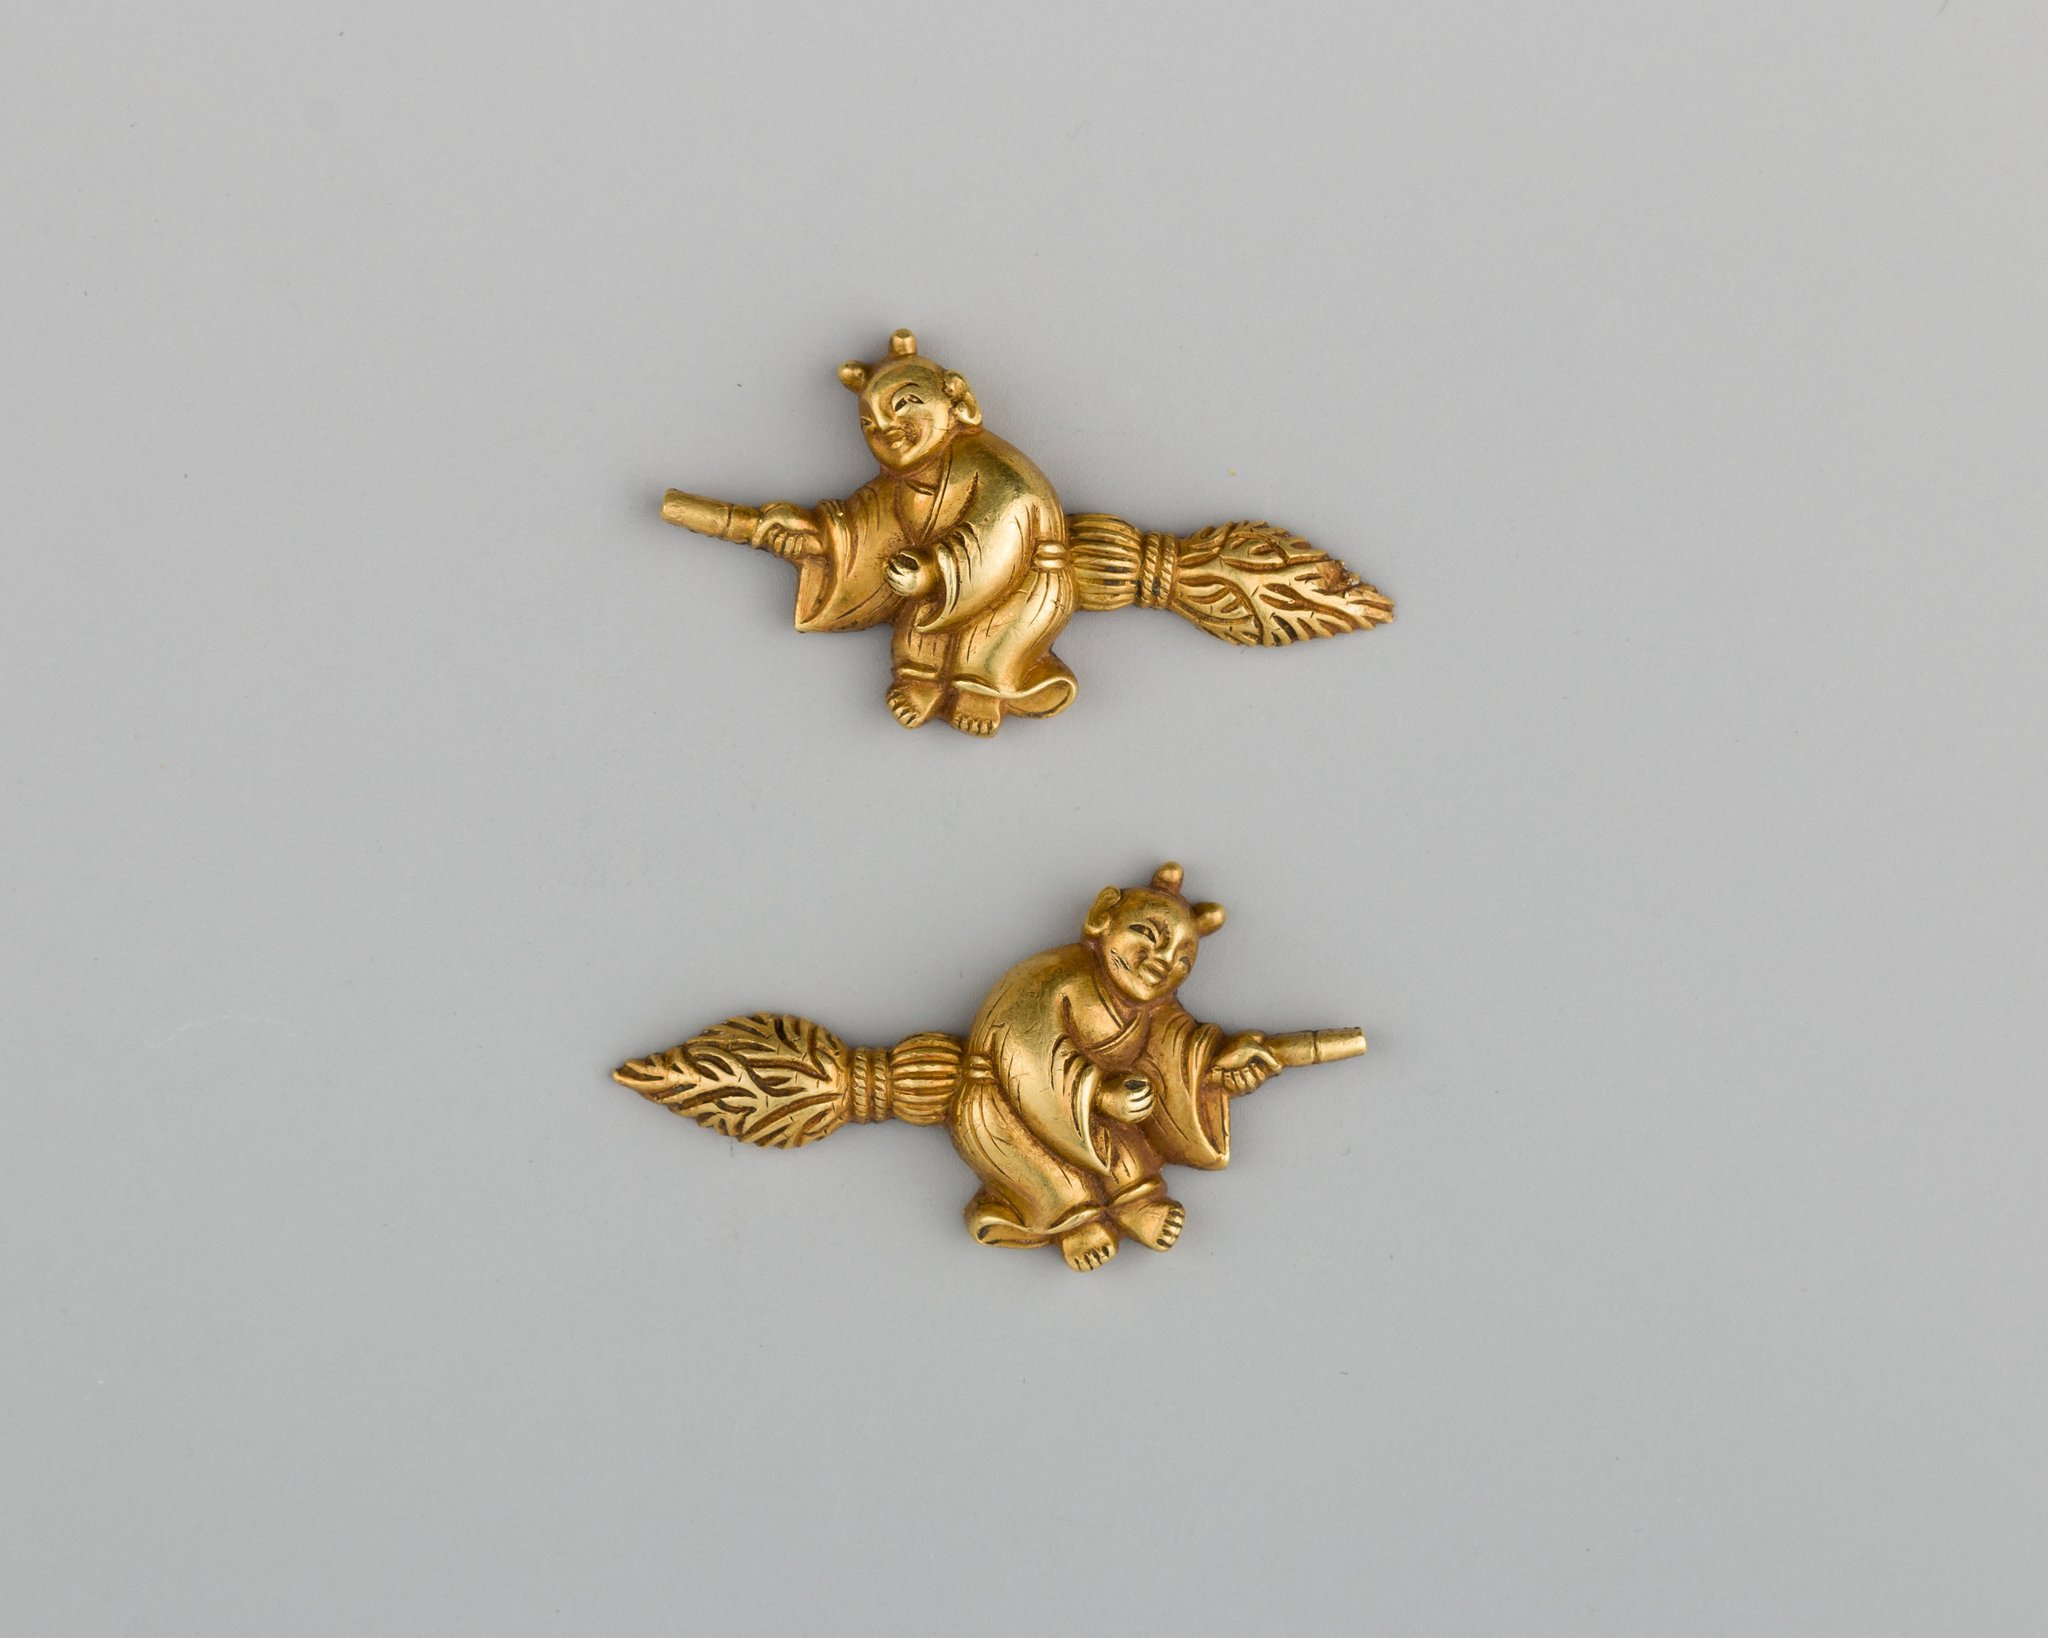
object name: pair of sword grip ornament menuki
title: Pair of Sword-Grip Ornaments (Menuki)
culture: japanese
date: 1701-1800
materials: gold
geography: japan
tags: men